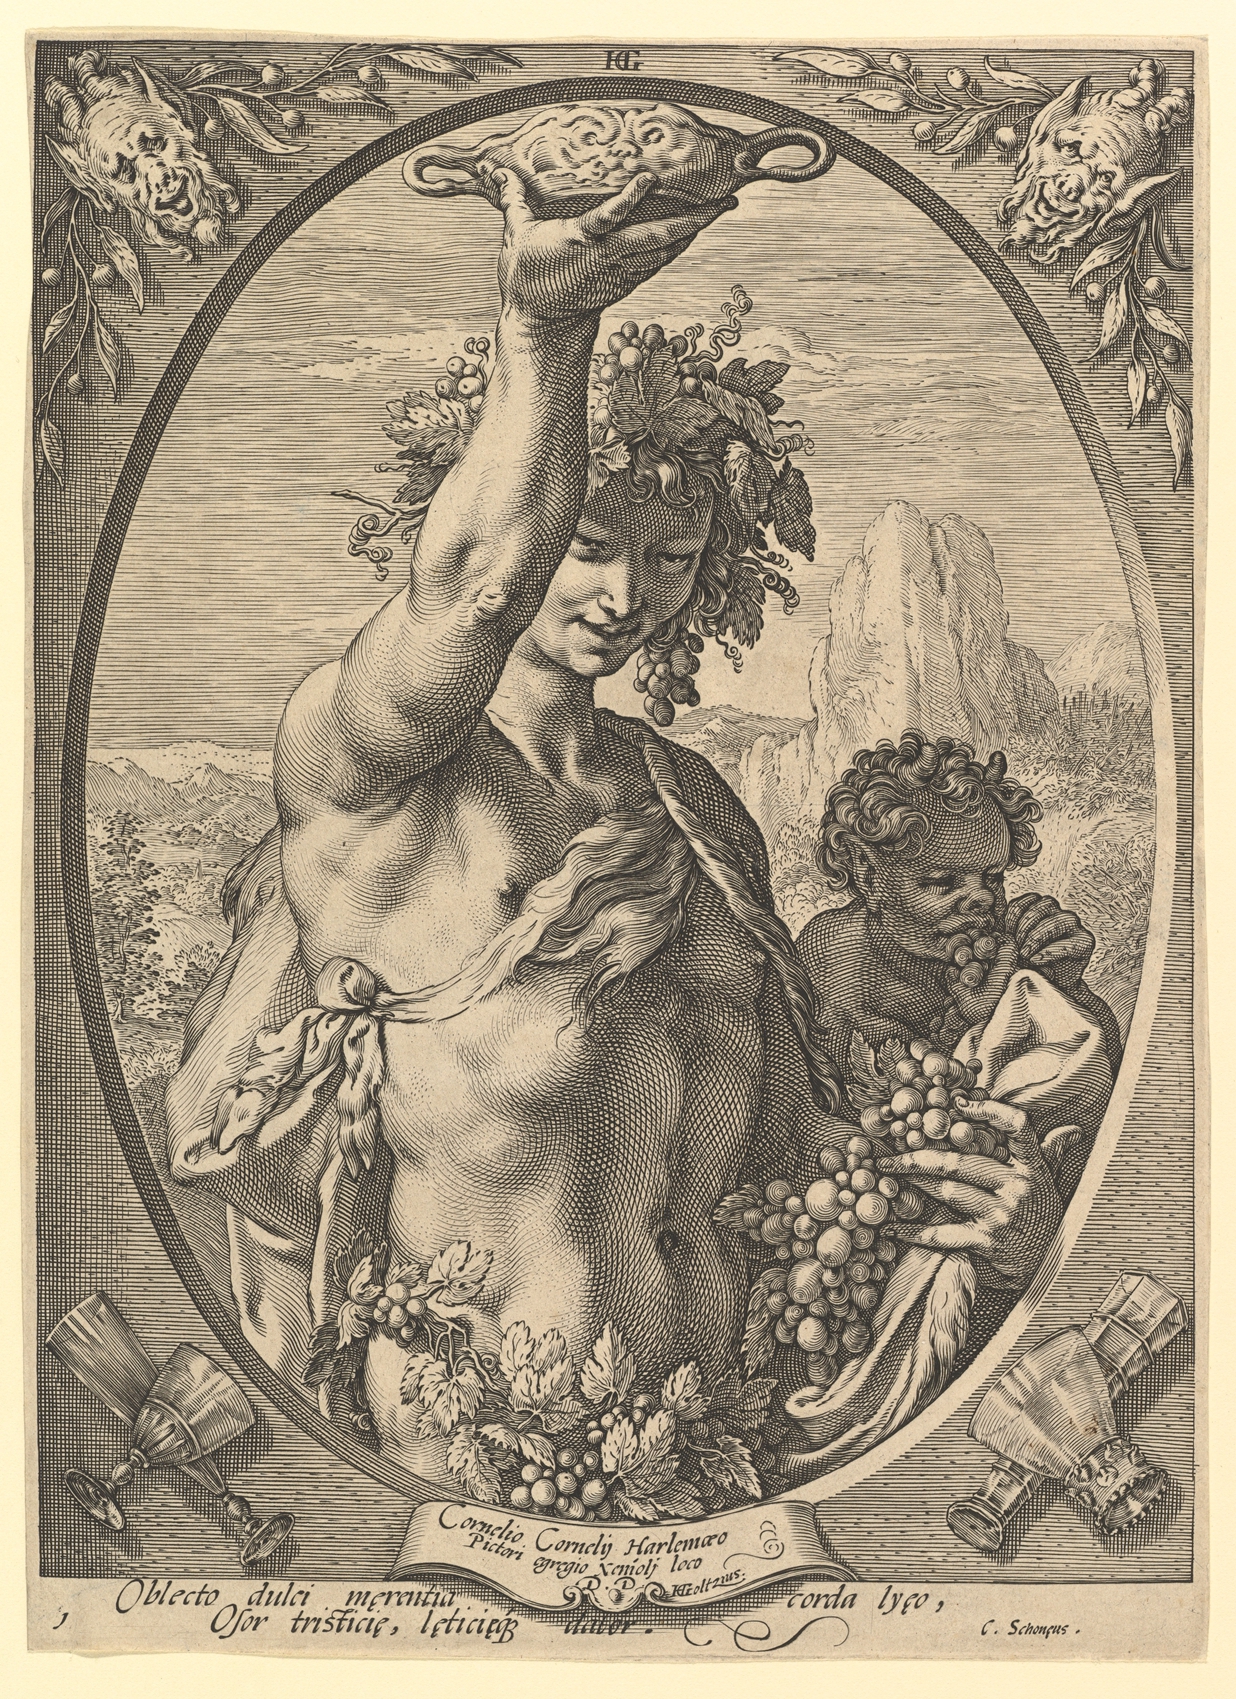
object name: print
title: Bacchus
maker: hendrick goltzius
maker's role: artist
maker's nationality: netherlandish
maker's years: 1558-1617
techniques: engraving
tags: grapes,bacchus